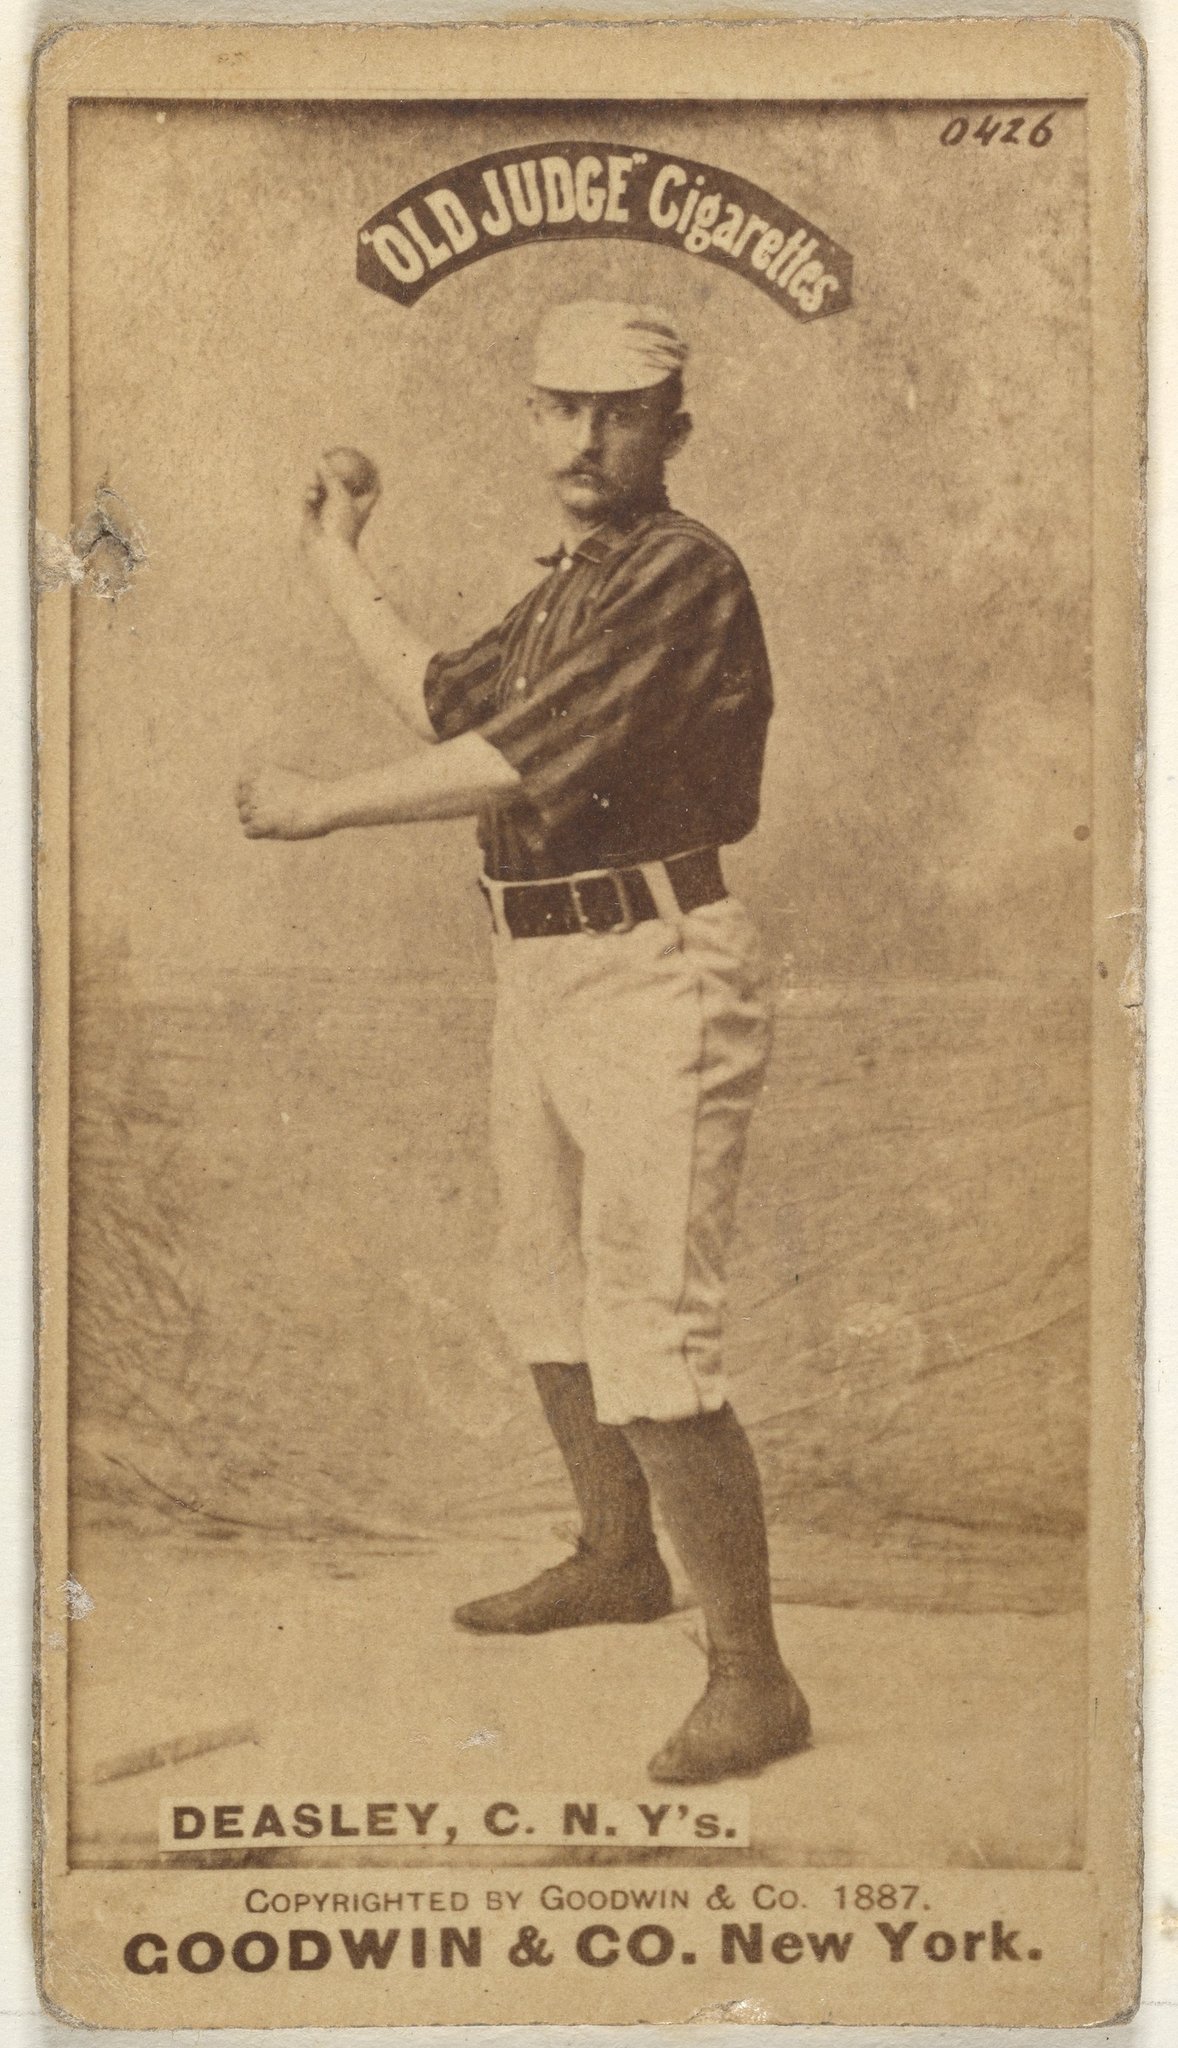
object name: baseball card, photograph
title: Thomas H. "Pat" Deasley, Catcher, New York, from the Old Judge series (N172) for Old Judge Cigarettes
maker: goodwin & company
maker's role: publisher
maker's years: 1850-1950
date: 1887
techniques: albumen silver print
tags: men,portraits,baseball,athletes